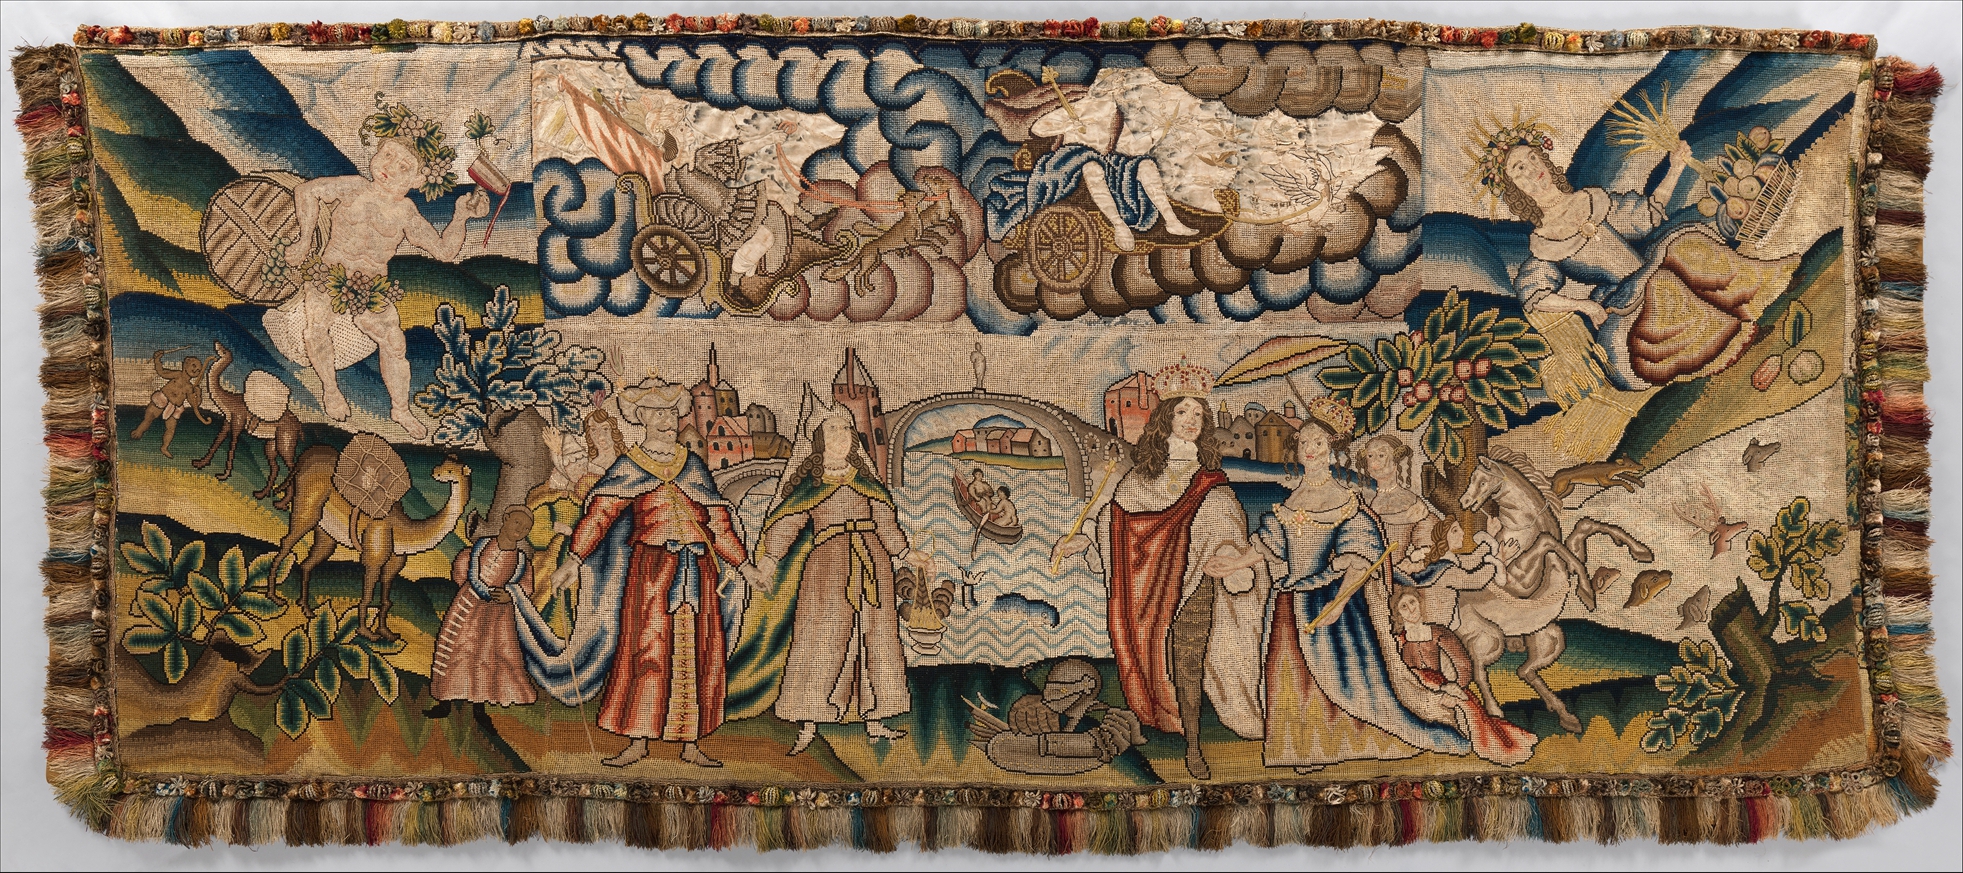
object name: panel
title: Panel from a table carpet showing the Four Continents, the Seasons, and Four Planets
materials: linen, metal, parchment, silk, thread, wool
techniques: embroidery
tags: children,men,women,camels,horses